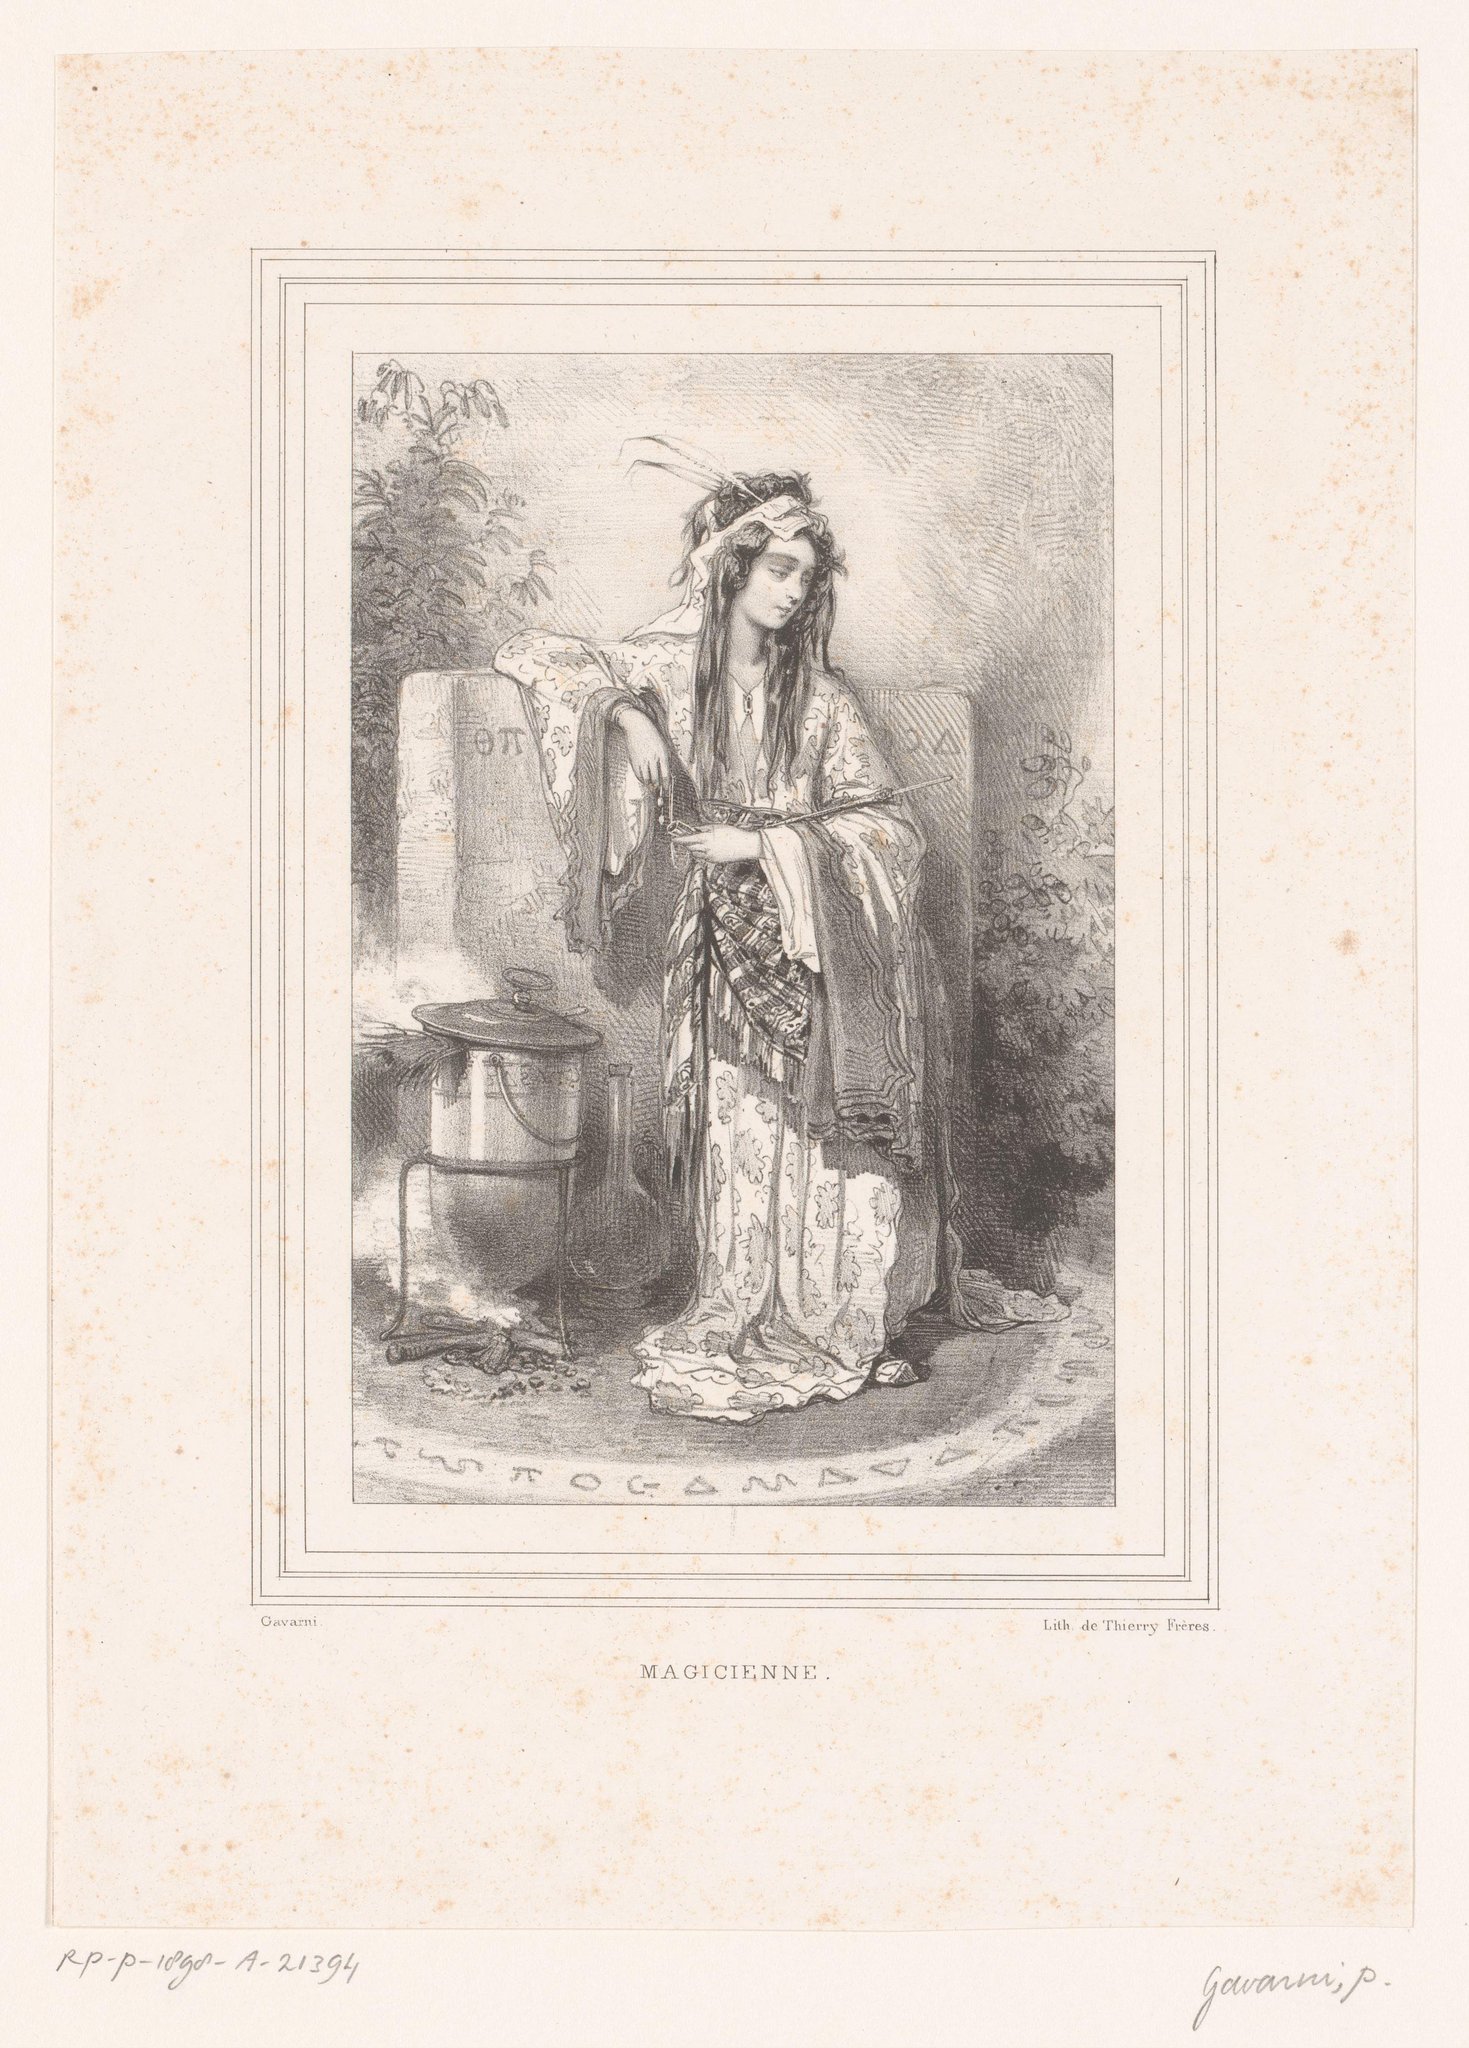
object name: print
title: Tovenares in een magische cirkel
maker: paul gavarni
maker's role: draughtsman, print maker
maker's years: 1804-1866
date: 1835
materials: paper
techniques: lithograph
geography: paris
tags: magic signs and objects (numbers, words, etc.), witch, sorceress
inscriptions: collector's mark: Lugt 964